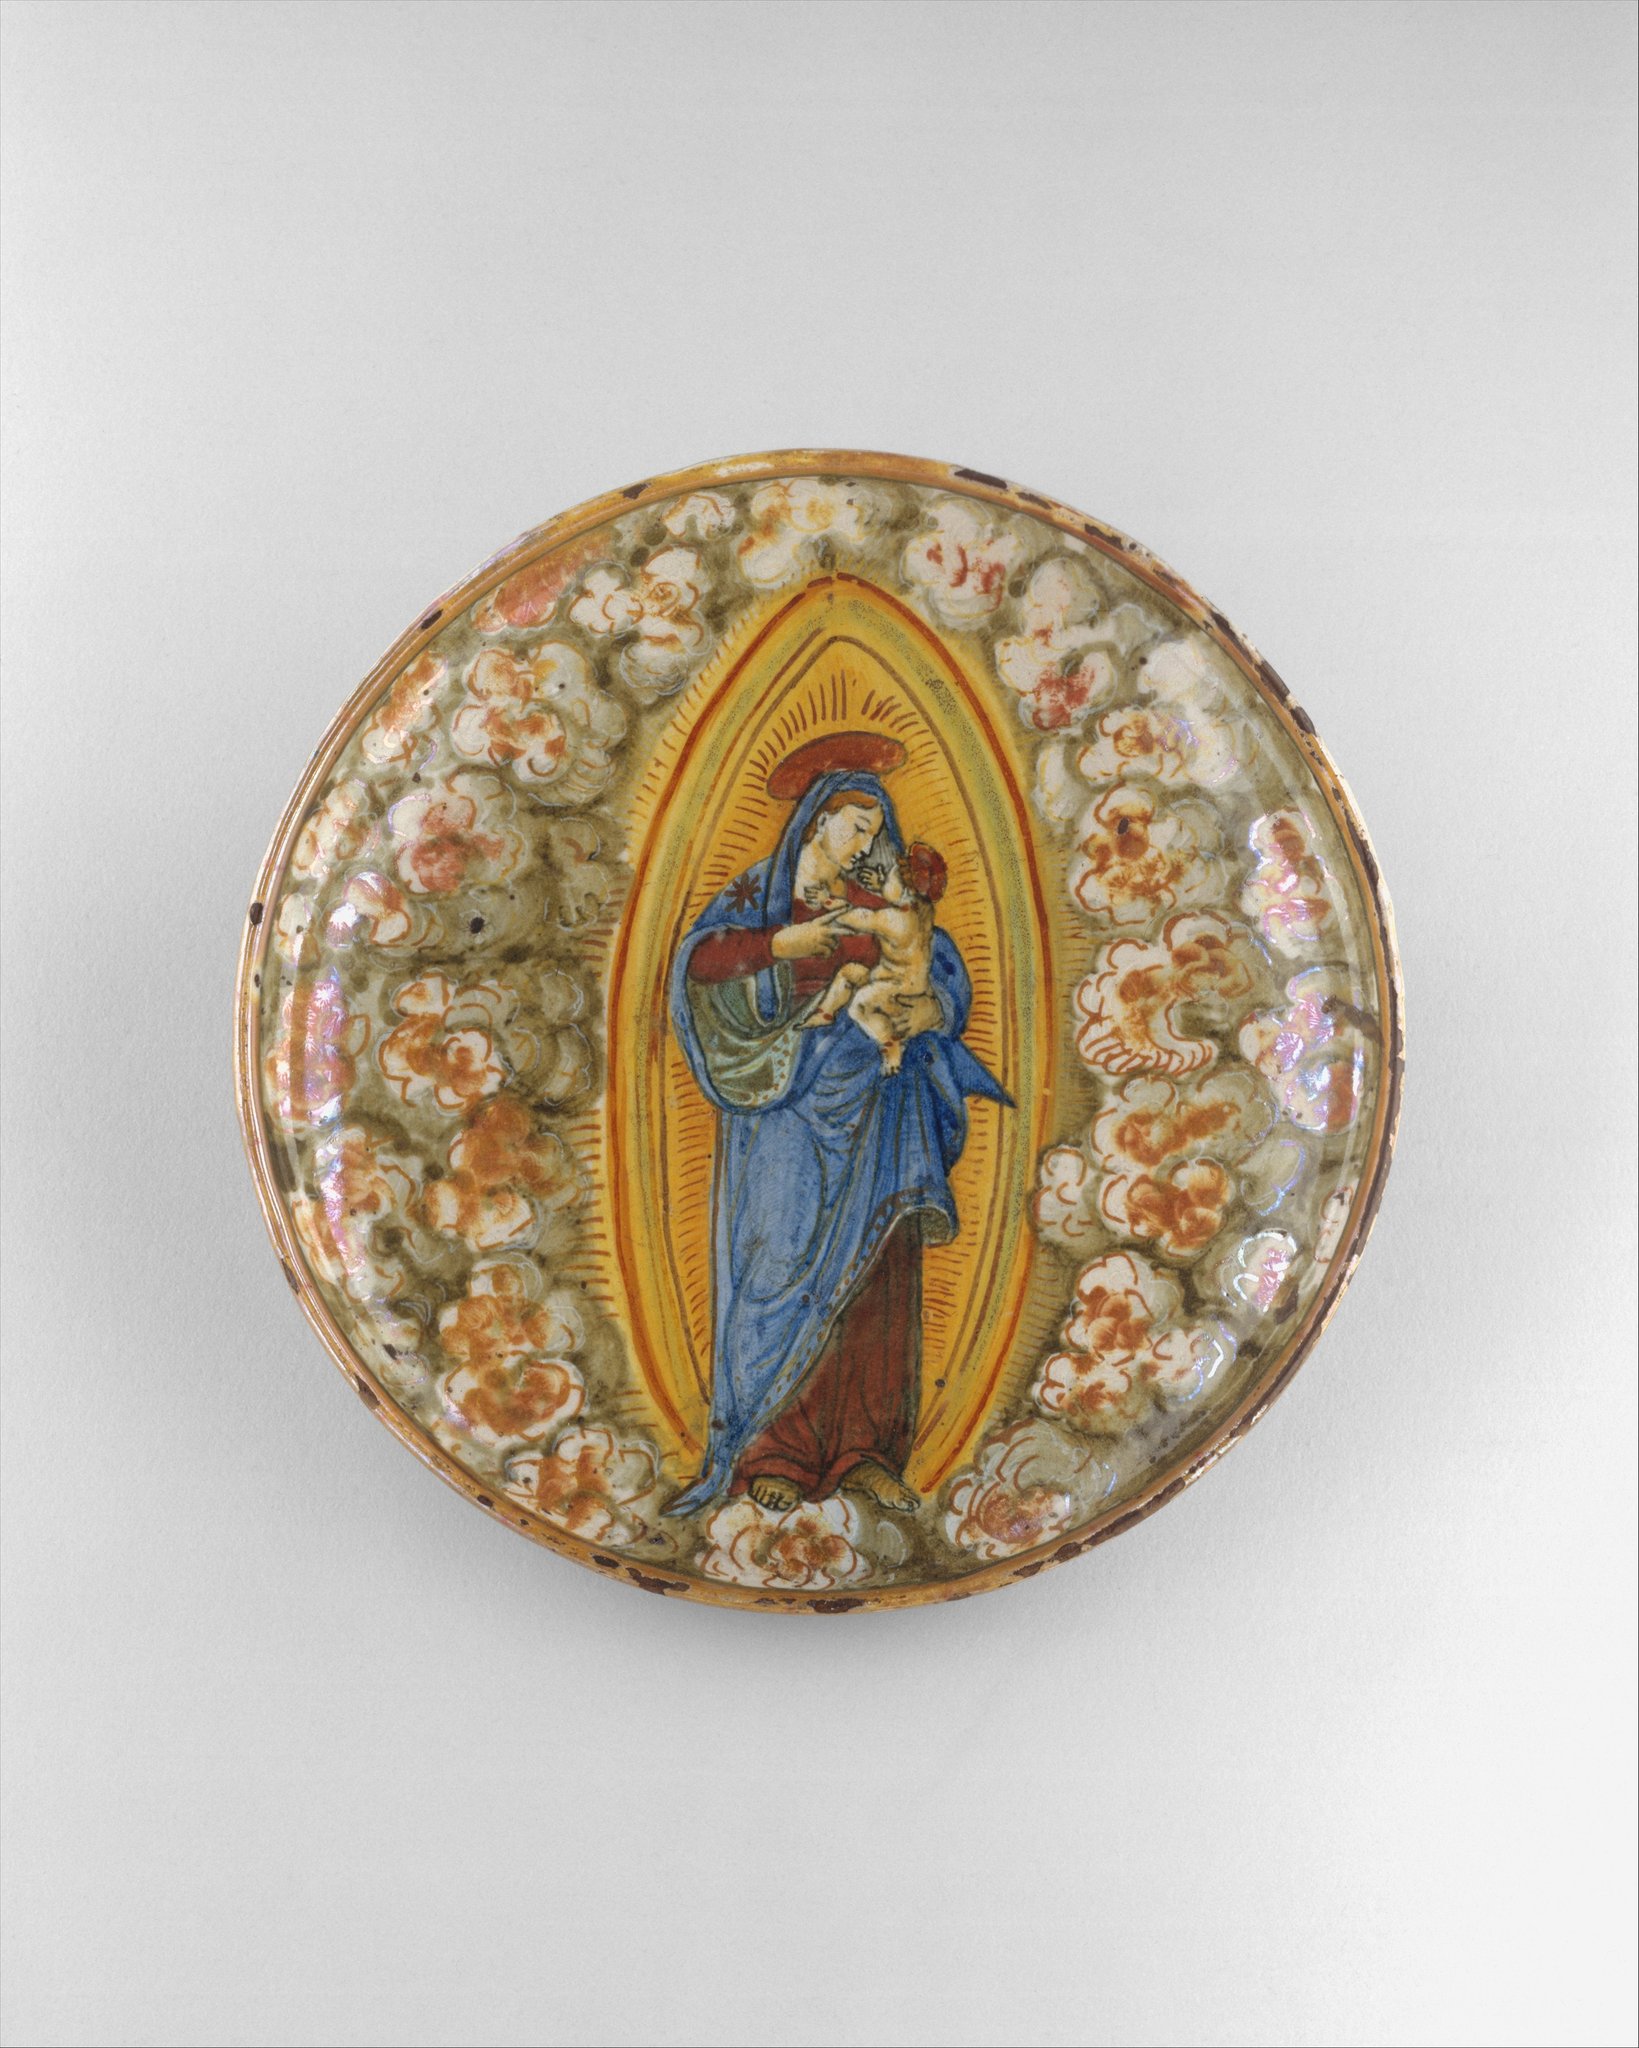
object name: dish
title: Dish (coppa)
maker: maestro giorgio andreoli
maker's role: artist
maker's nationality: italian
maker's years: 1500-1550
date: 1530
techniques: maiolica, glazing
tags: madonna and child